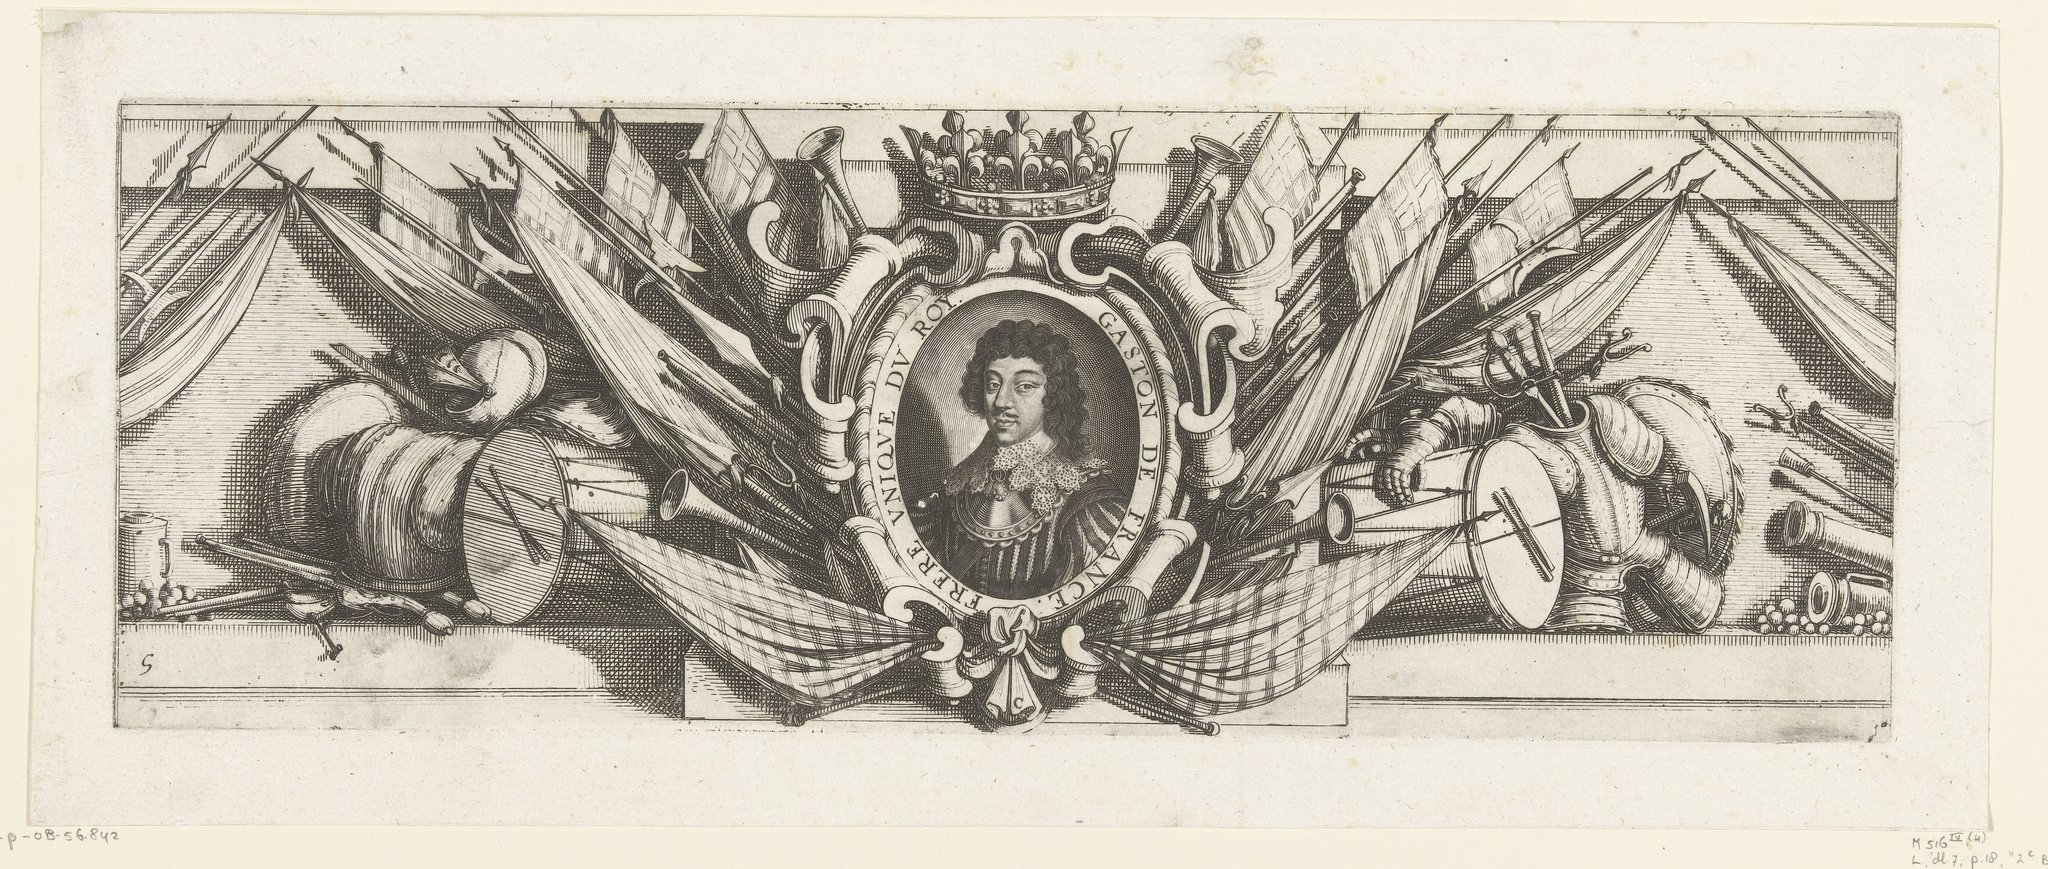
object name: print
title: Beleg van La Rochelle, september 1627-oktober 1628 (randwerk, deel middenonder)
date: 1628-1631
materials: paper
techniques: engraving, etching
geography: paris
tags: gaston jean-baptiste hertog van orléans, historical persons, ornament ~ cartouche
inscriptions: collector's mark: Lugt 240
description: Zestiende deel (randwerk, deel middenonder) van een prent van het beleg van het hugenotenbolwerk La Rochelle in de jaren 1627 en 1628, dat werd uitgevoerd in opdracht van de Franse koning door het Franse leger onder aanvoering van kardinaal Richelieu. Op dit blad een portret van de broer van Lodewijk XIII, Gaston, in ovaal met randschrift, omgeven door een kroon en militaire attributen.